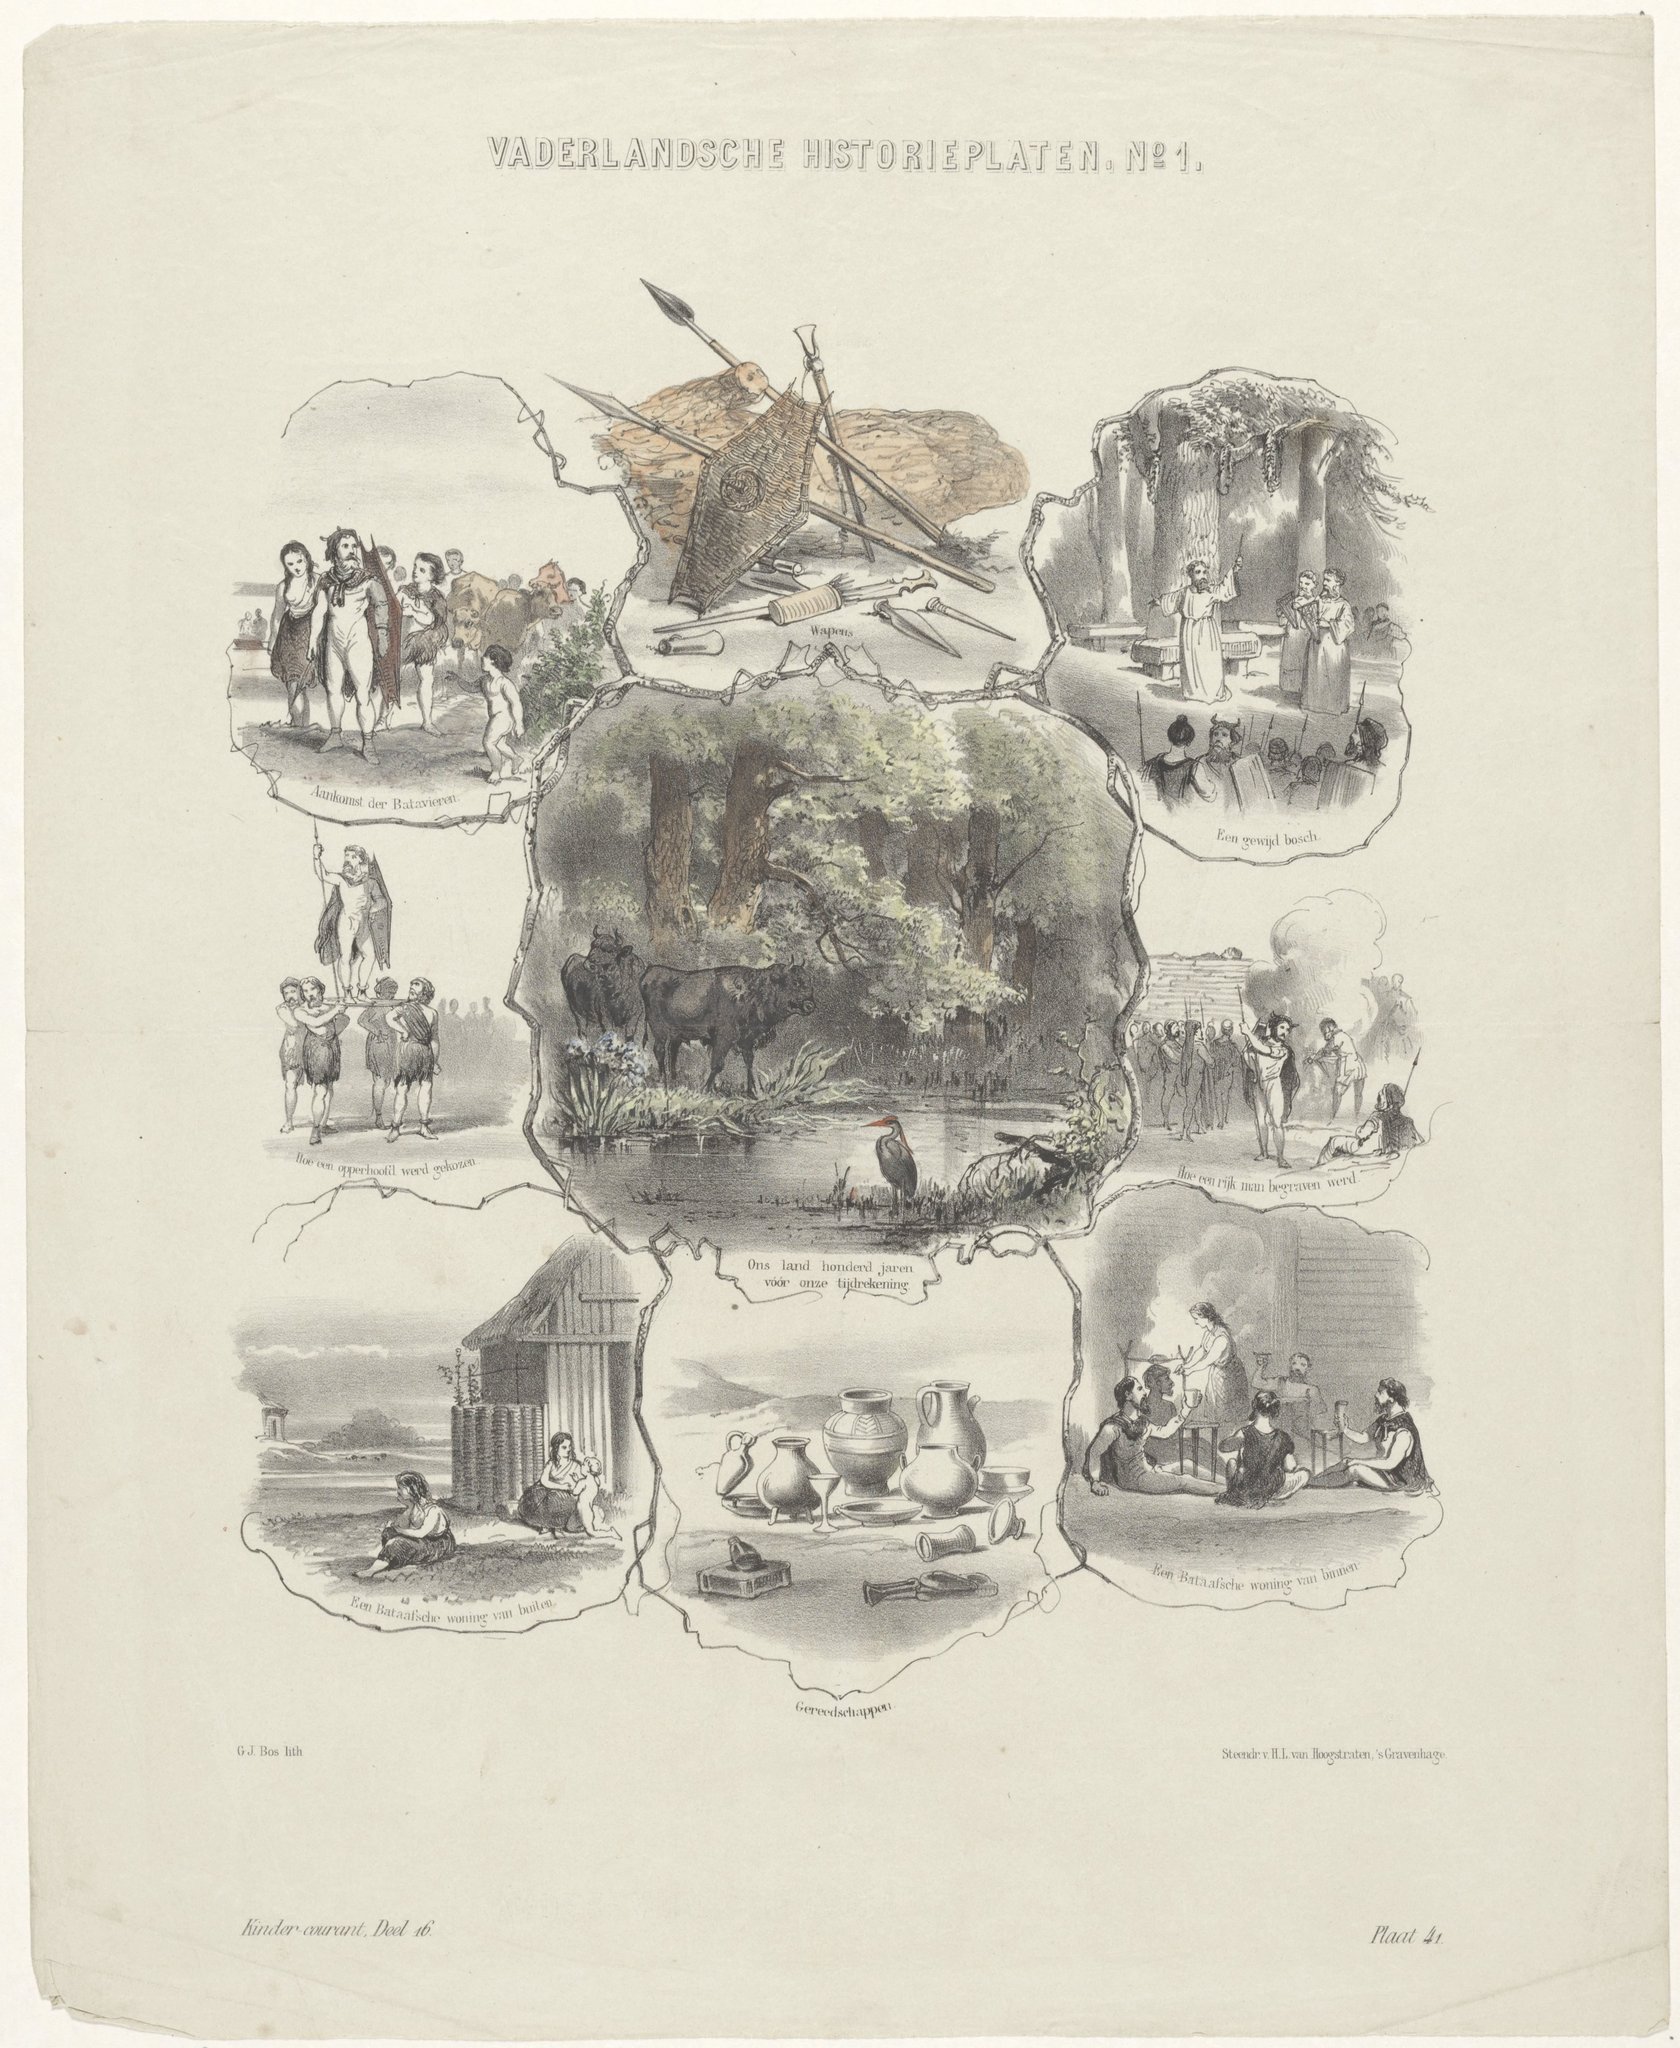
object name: kinderprent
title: Scènes uit het leven van de Batavieren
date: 1859-1896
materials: paper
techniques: hand coloring, lithograph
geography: the hague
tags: extinct, 'historical' peoples (batavieren) (+ anthropological characteristics emphasized)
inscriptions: collector's mark: Lugt 2228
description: In het midden een moerassig landschap met runderen en een vogel. Daar omheen acht scènes uit het leven van de Batavieren met een korte toelichting eronder. Boven- en onder wapens en gereedschappen. Verder zijn afgebeeld: de aankomst van de Batavieren, een gewijd bos, hoe een opperhoofd wordt gekozen, een begrafenisritueel en een woning van binnen en van buiten. Deze prent werd uitgegeven bij de Kinder-Courant.